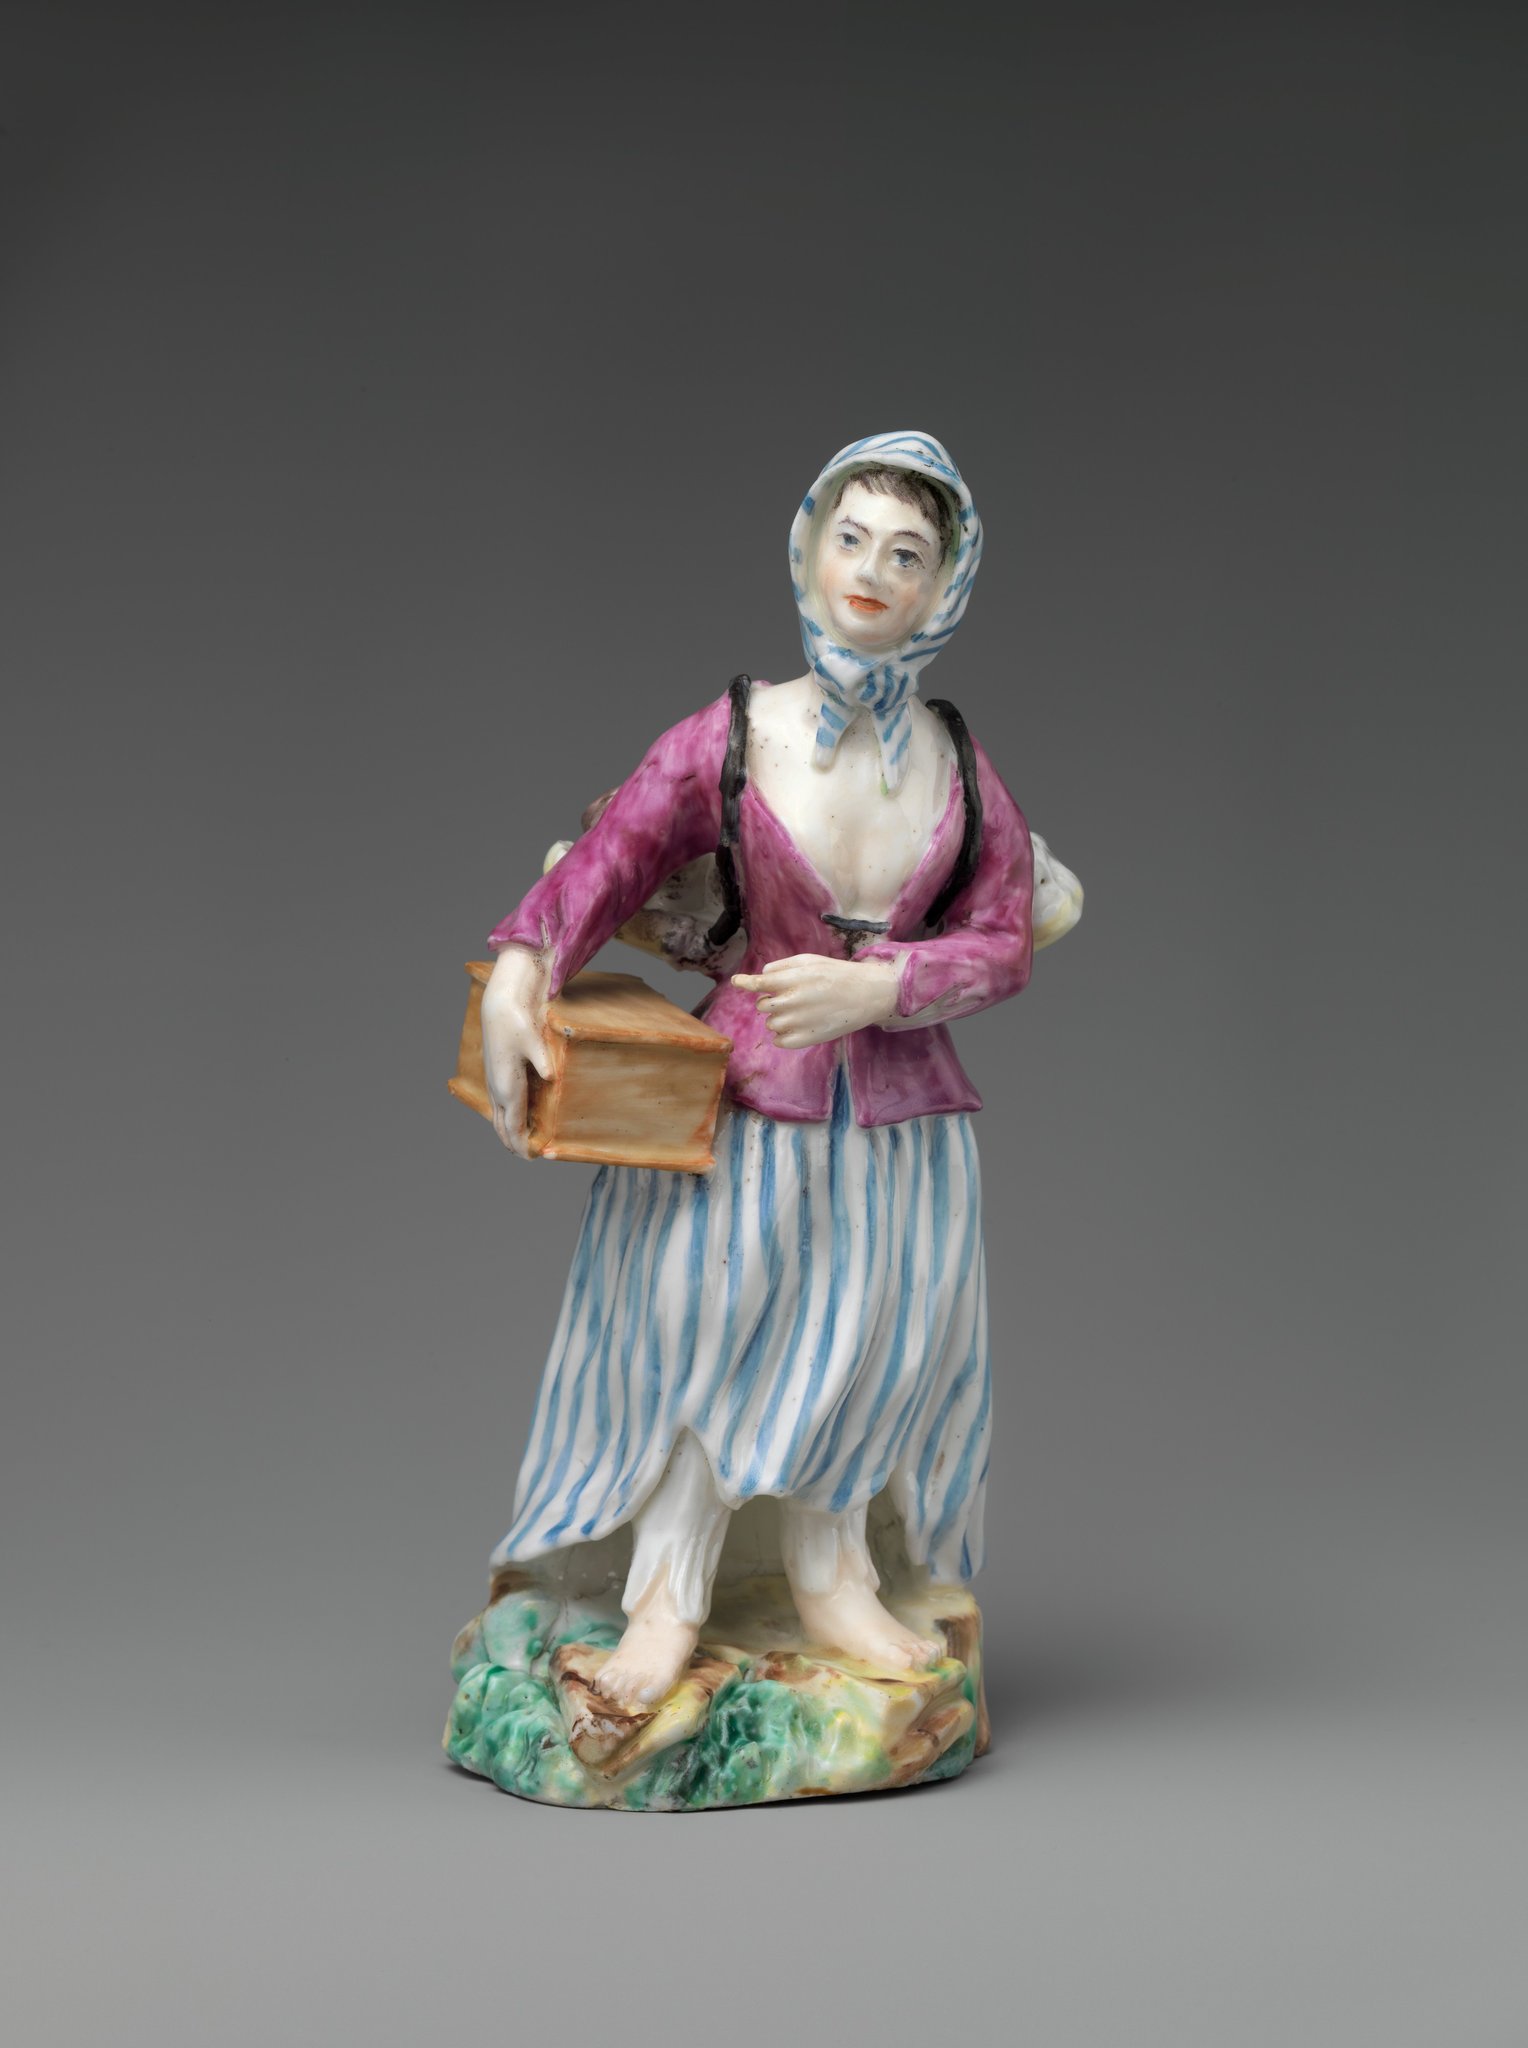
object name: figure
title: Peasant Woman with Child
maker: mennecy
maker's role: factory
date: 1750-1760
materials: soft paste porcelain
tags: women